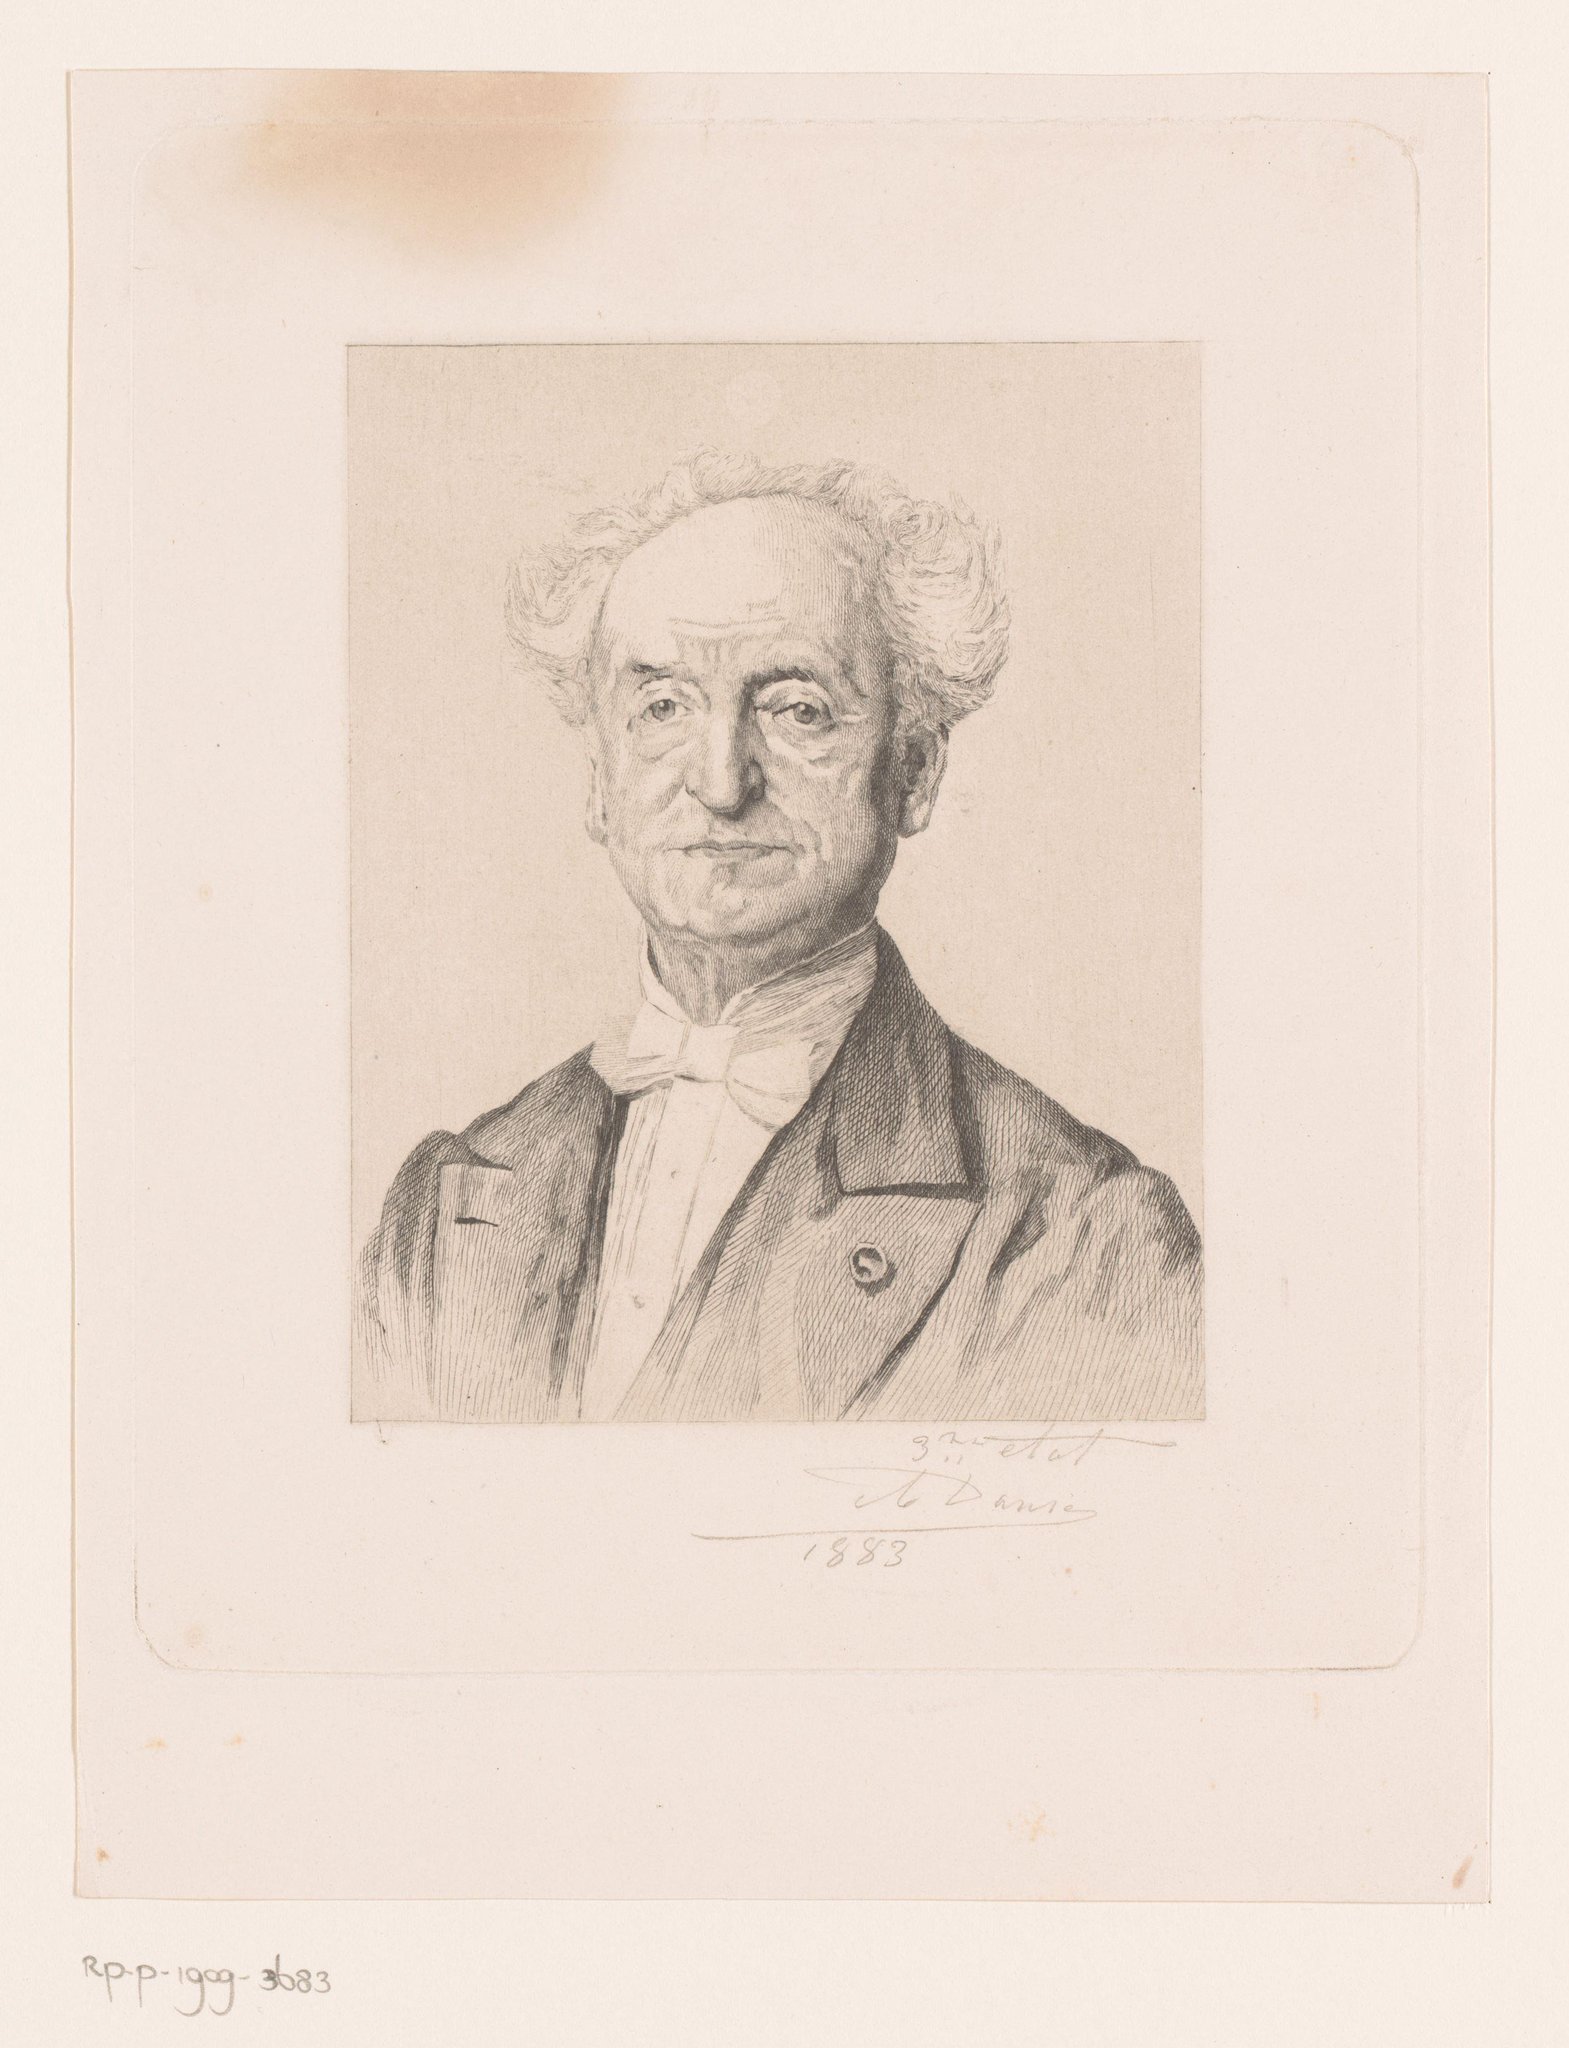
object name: print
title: Portret van een onbekende man met witte vlinderstrik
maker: auguste danse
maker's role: print maker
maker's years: 1829-1929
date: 1883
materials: paper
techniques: etching, intaglio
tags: adult man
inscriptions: annotation: ‘3me etat’, collector's mark: Lugt 2228